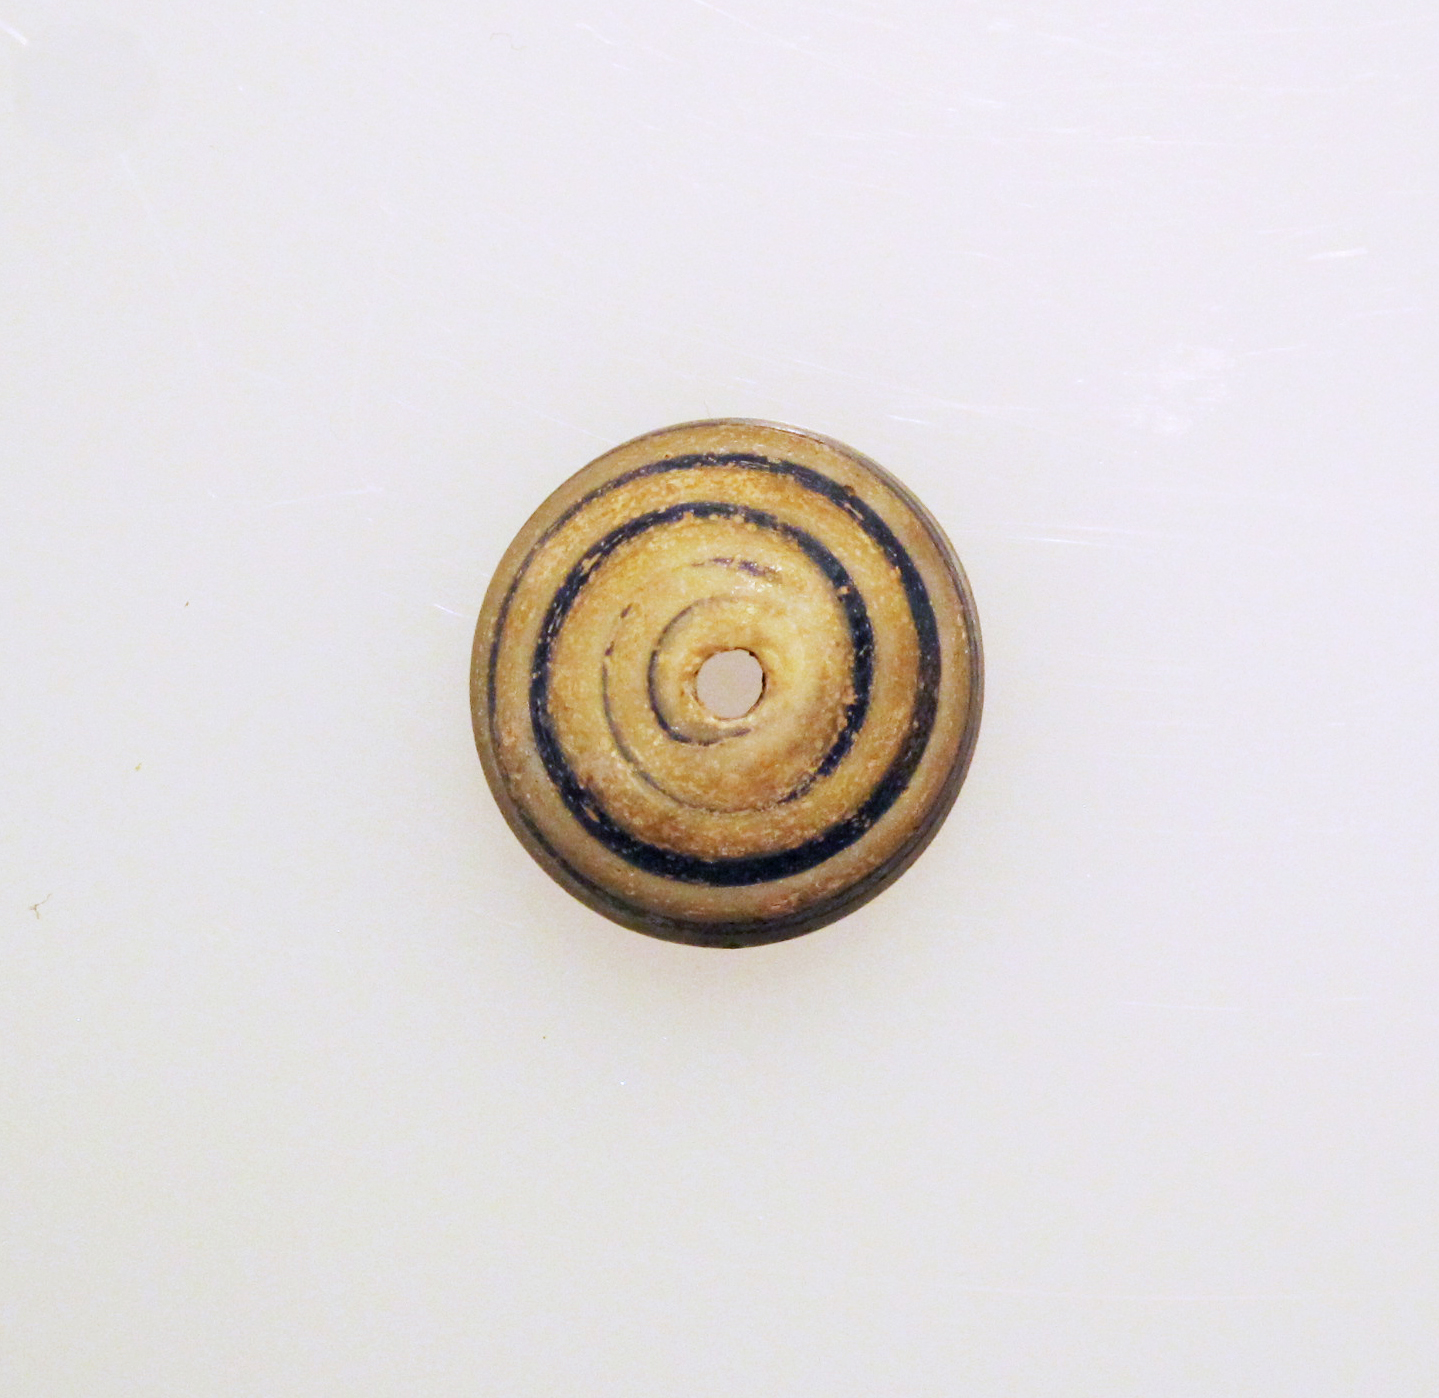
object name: spindle whorl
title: Glass spindle whorl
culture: roman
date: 1-200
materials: glass